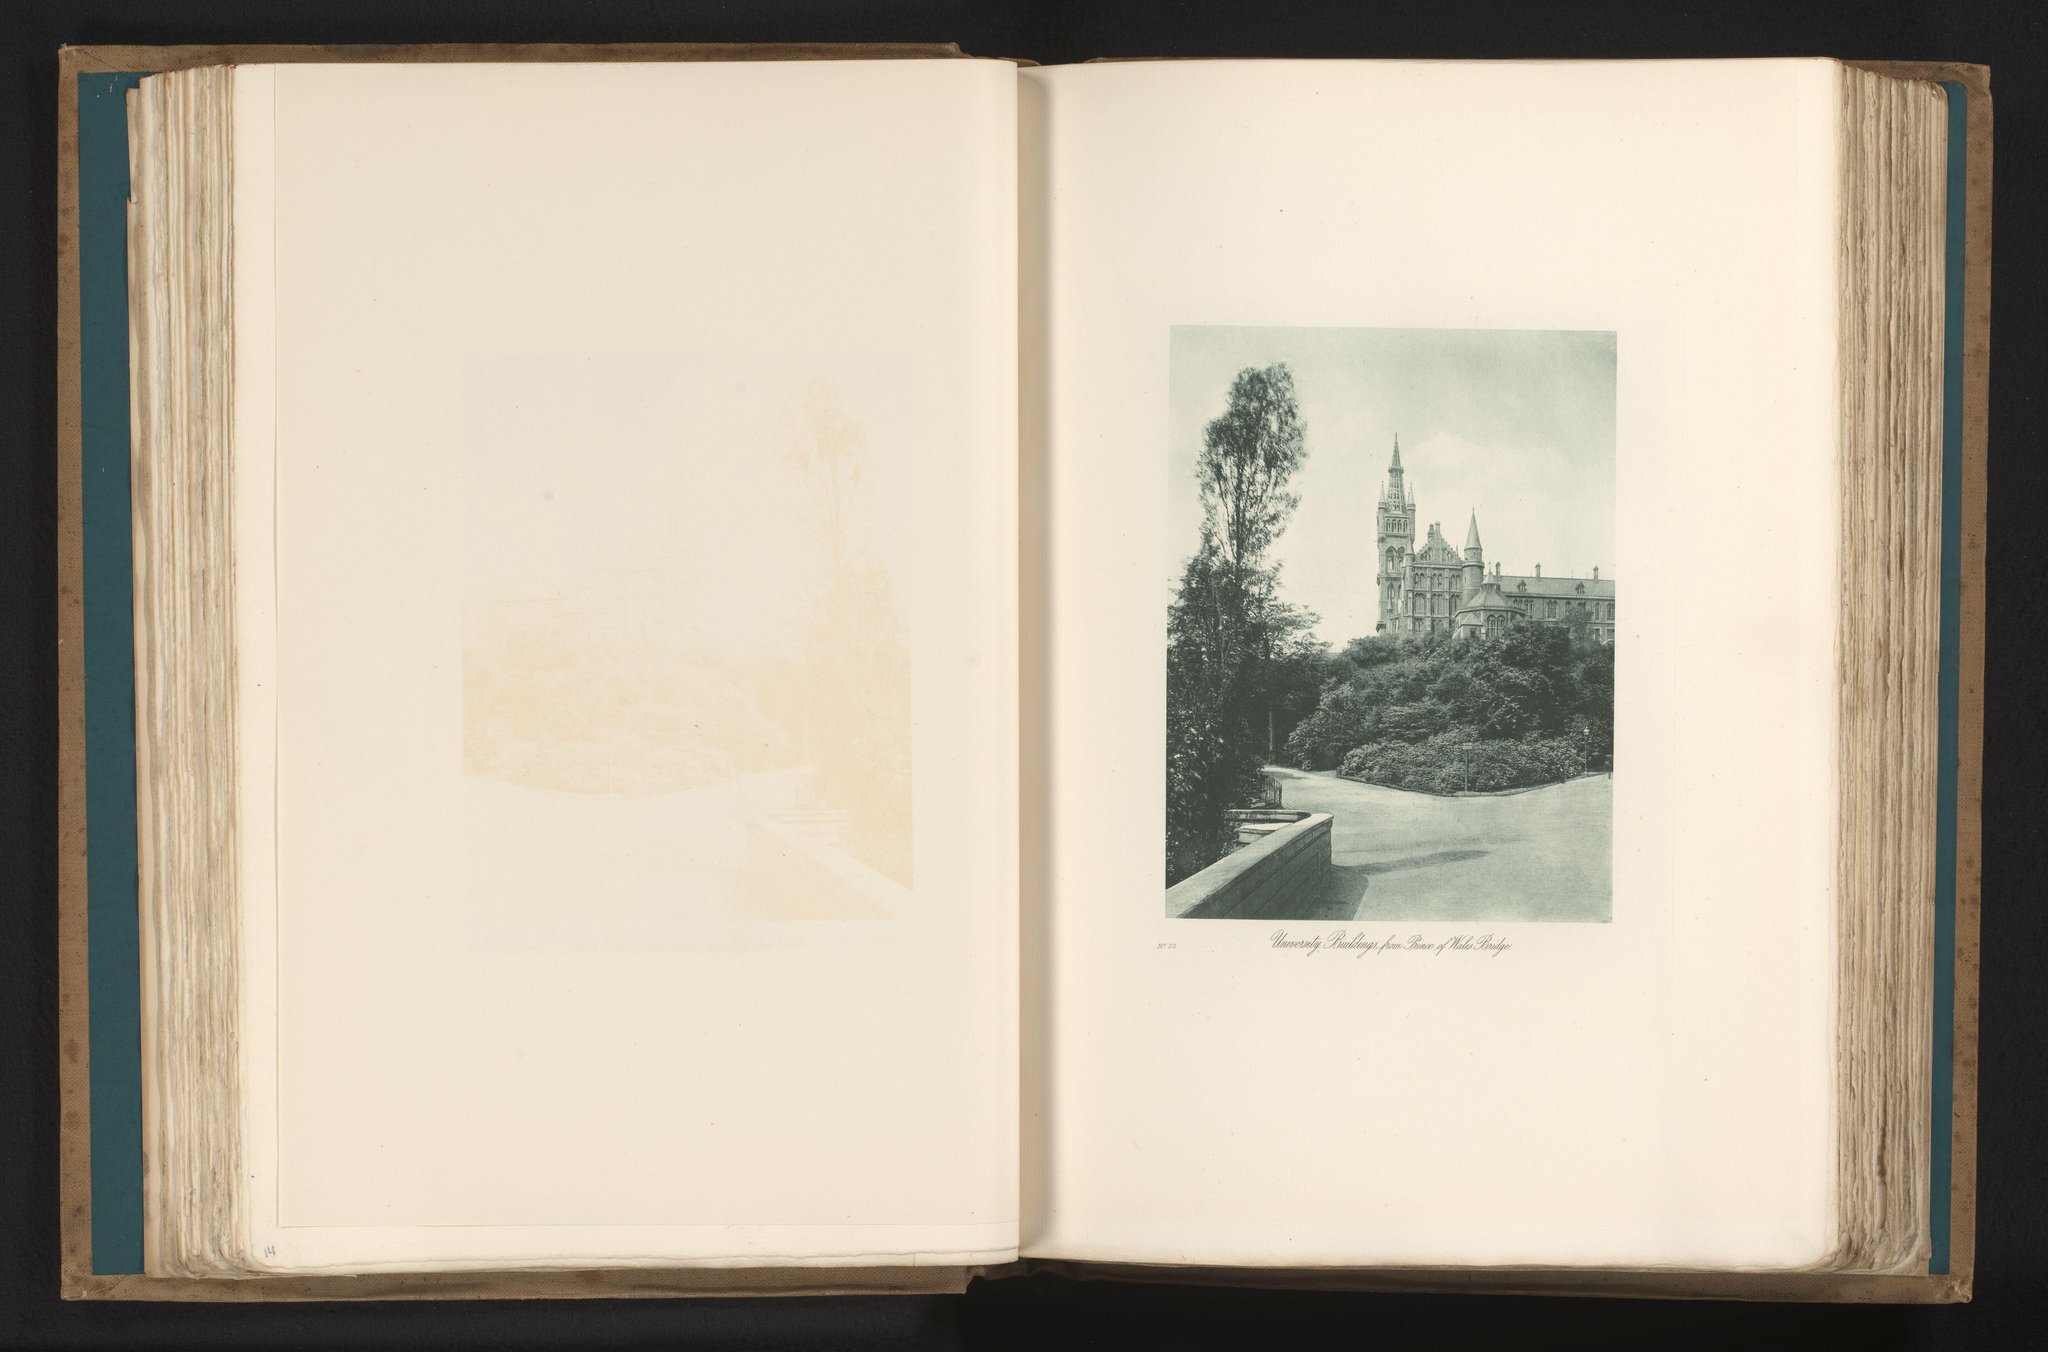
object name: photomechanical print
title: Universiteitsgebouwen van de universiteit van Glasgow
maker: Anonymous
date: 1886-1891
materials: paper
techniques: photoaquatint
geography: glasgow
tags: university (+ building ~ education, tuition), public gardens, park, glasgow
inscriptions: inscription: ‘No.22’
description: Prent op tiende ongenummerde pagina na pagina xxxiii.